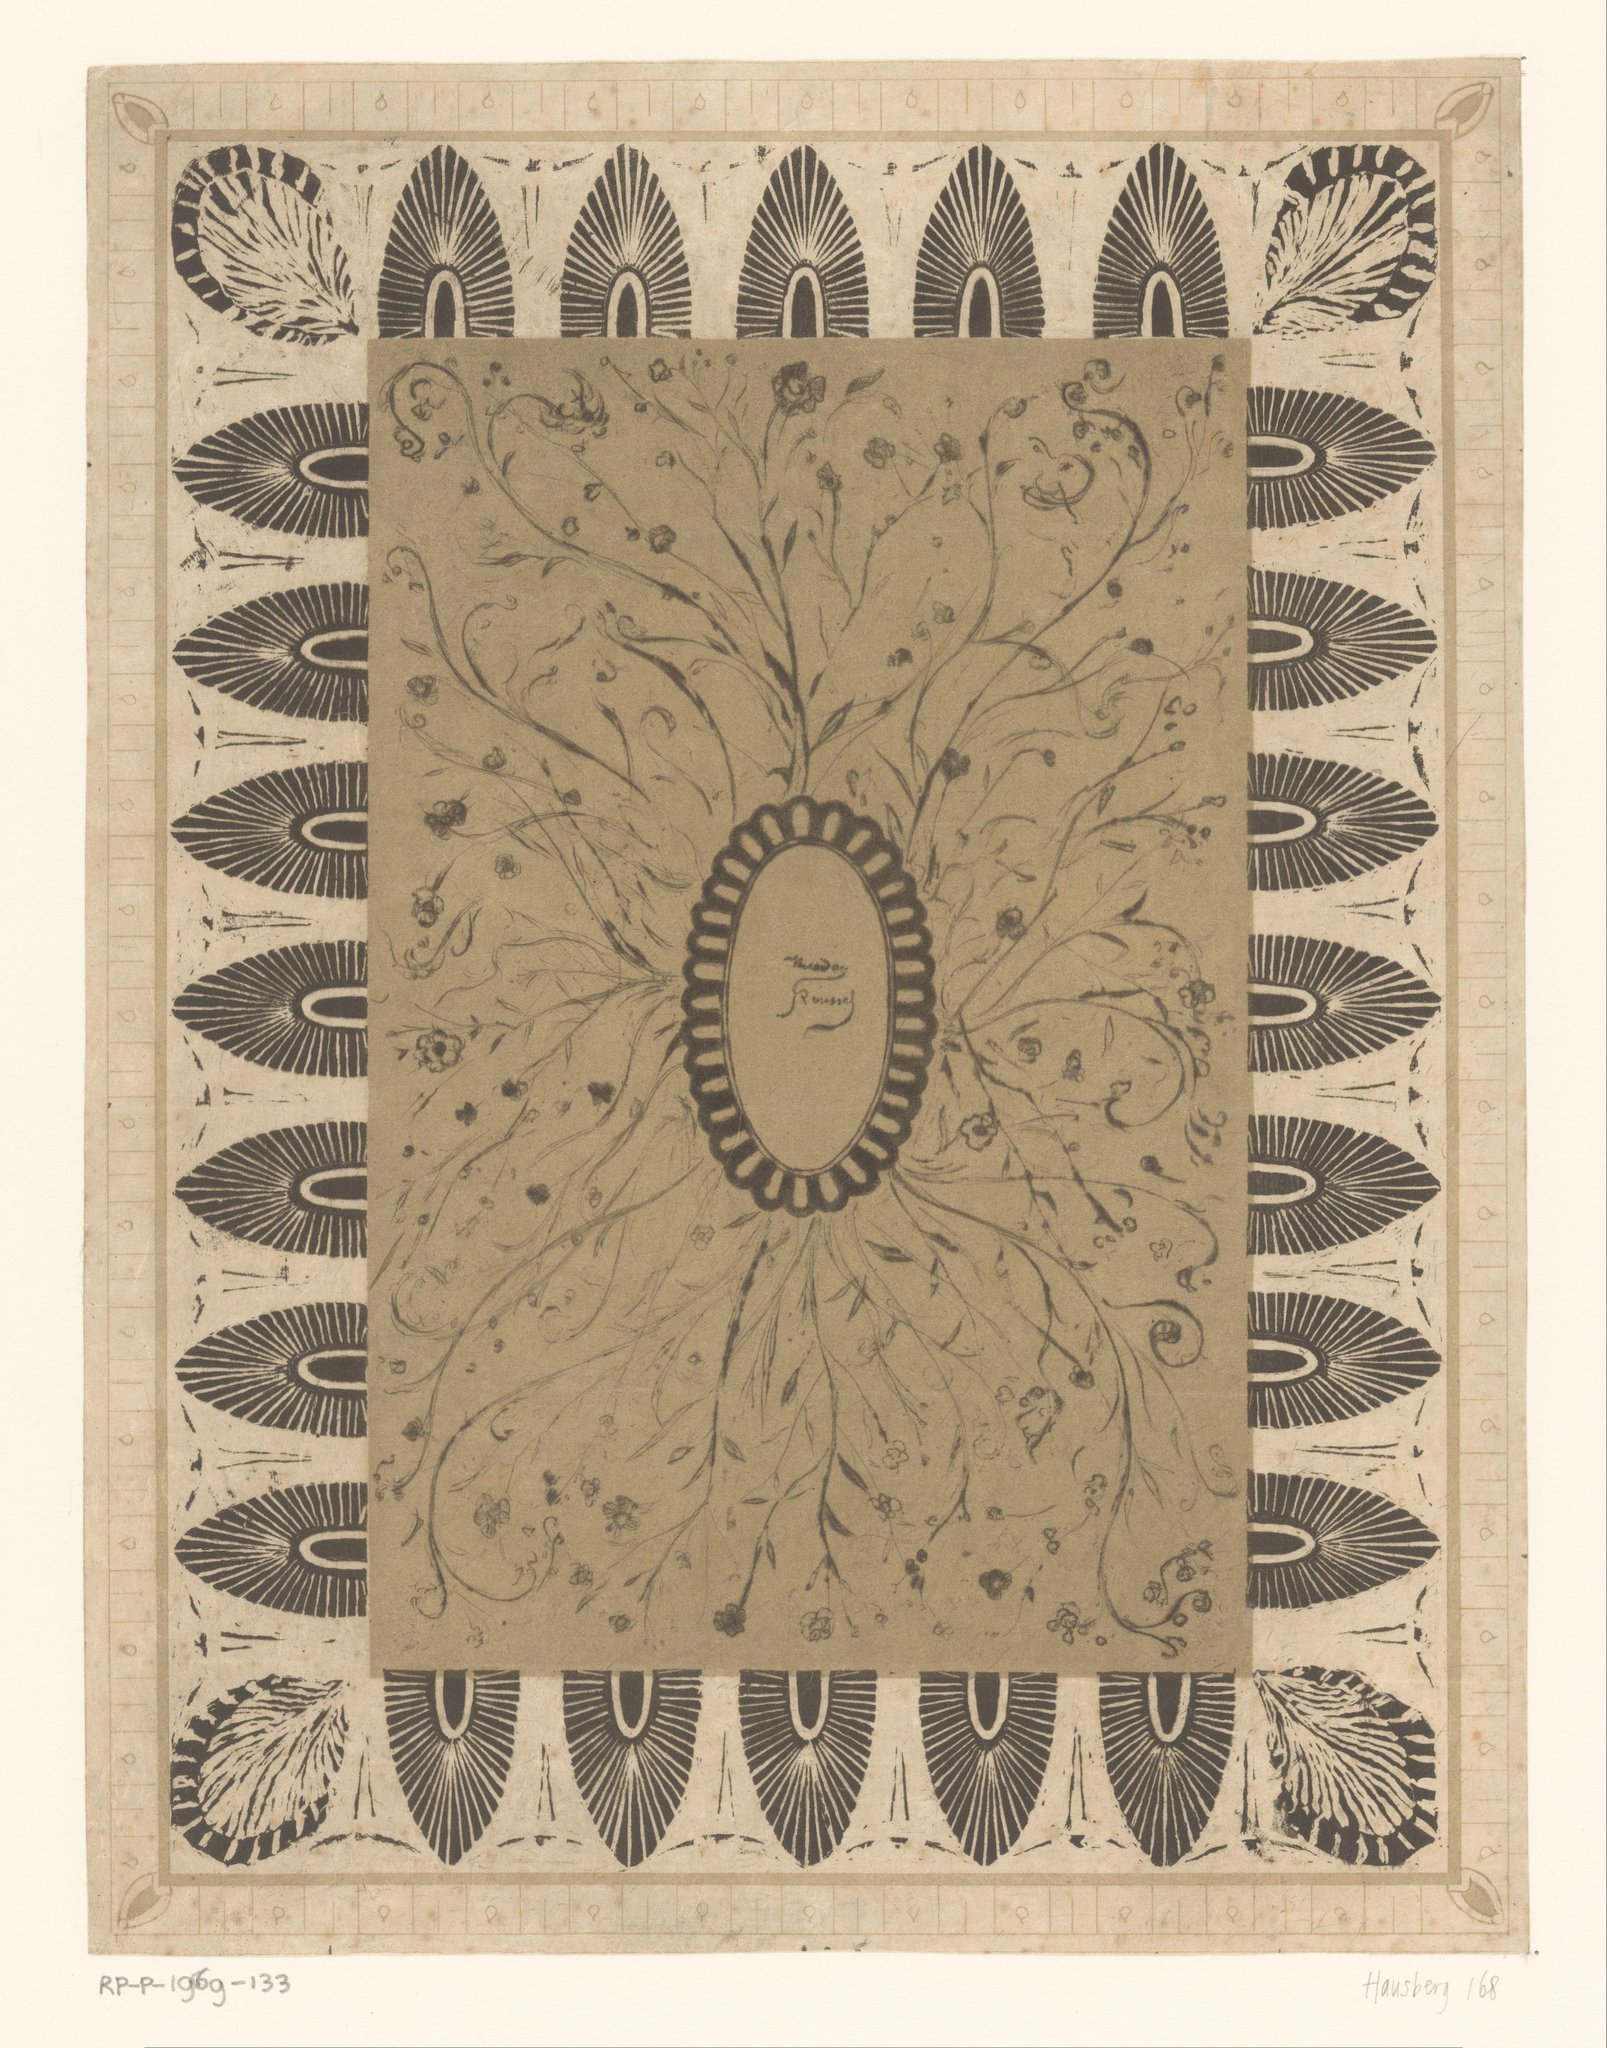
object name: print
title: Omlijsting met blad- en schelpvormige motieven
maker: théodore roussel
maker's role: print maker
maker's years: 1847-1926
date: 1897-1899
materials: paper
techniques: aquatint, drypoint, etching, soft ground etching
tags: scallop, shell ~ ornament - aa - stylized, frame of painting, etc., ornament derived from plant forms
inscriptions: collector's mark: Lugt 2228, collector's mark: Lugt 2760